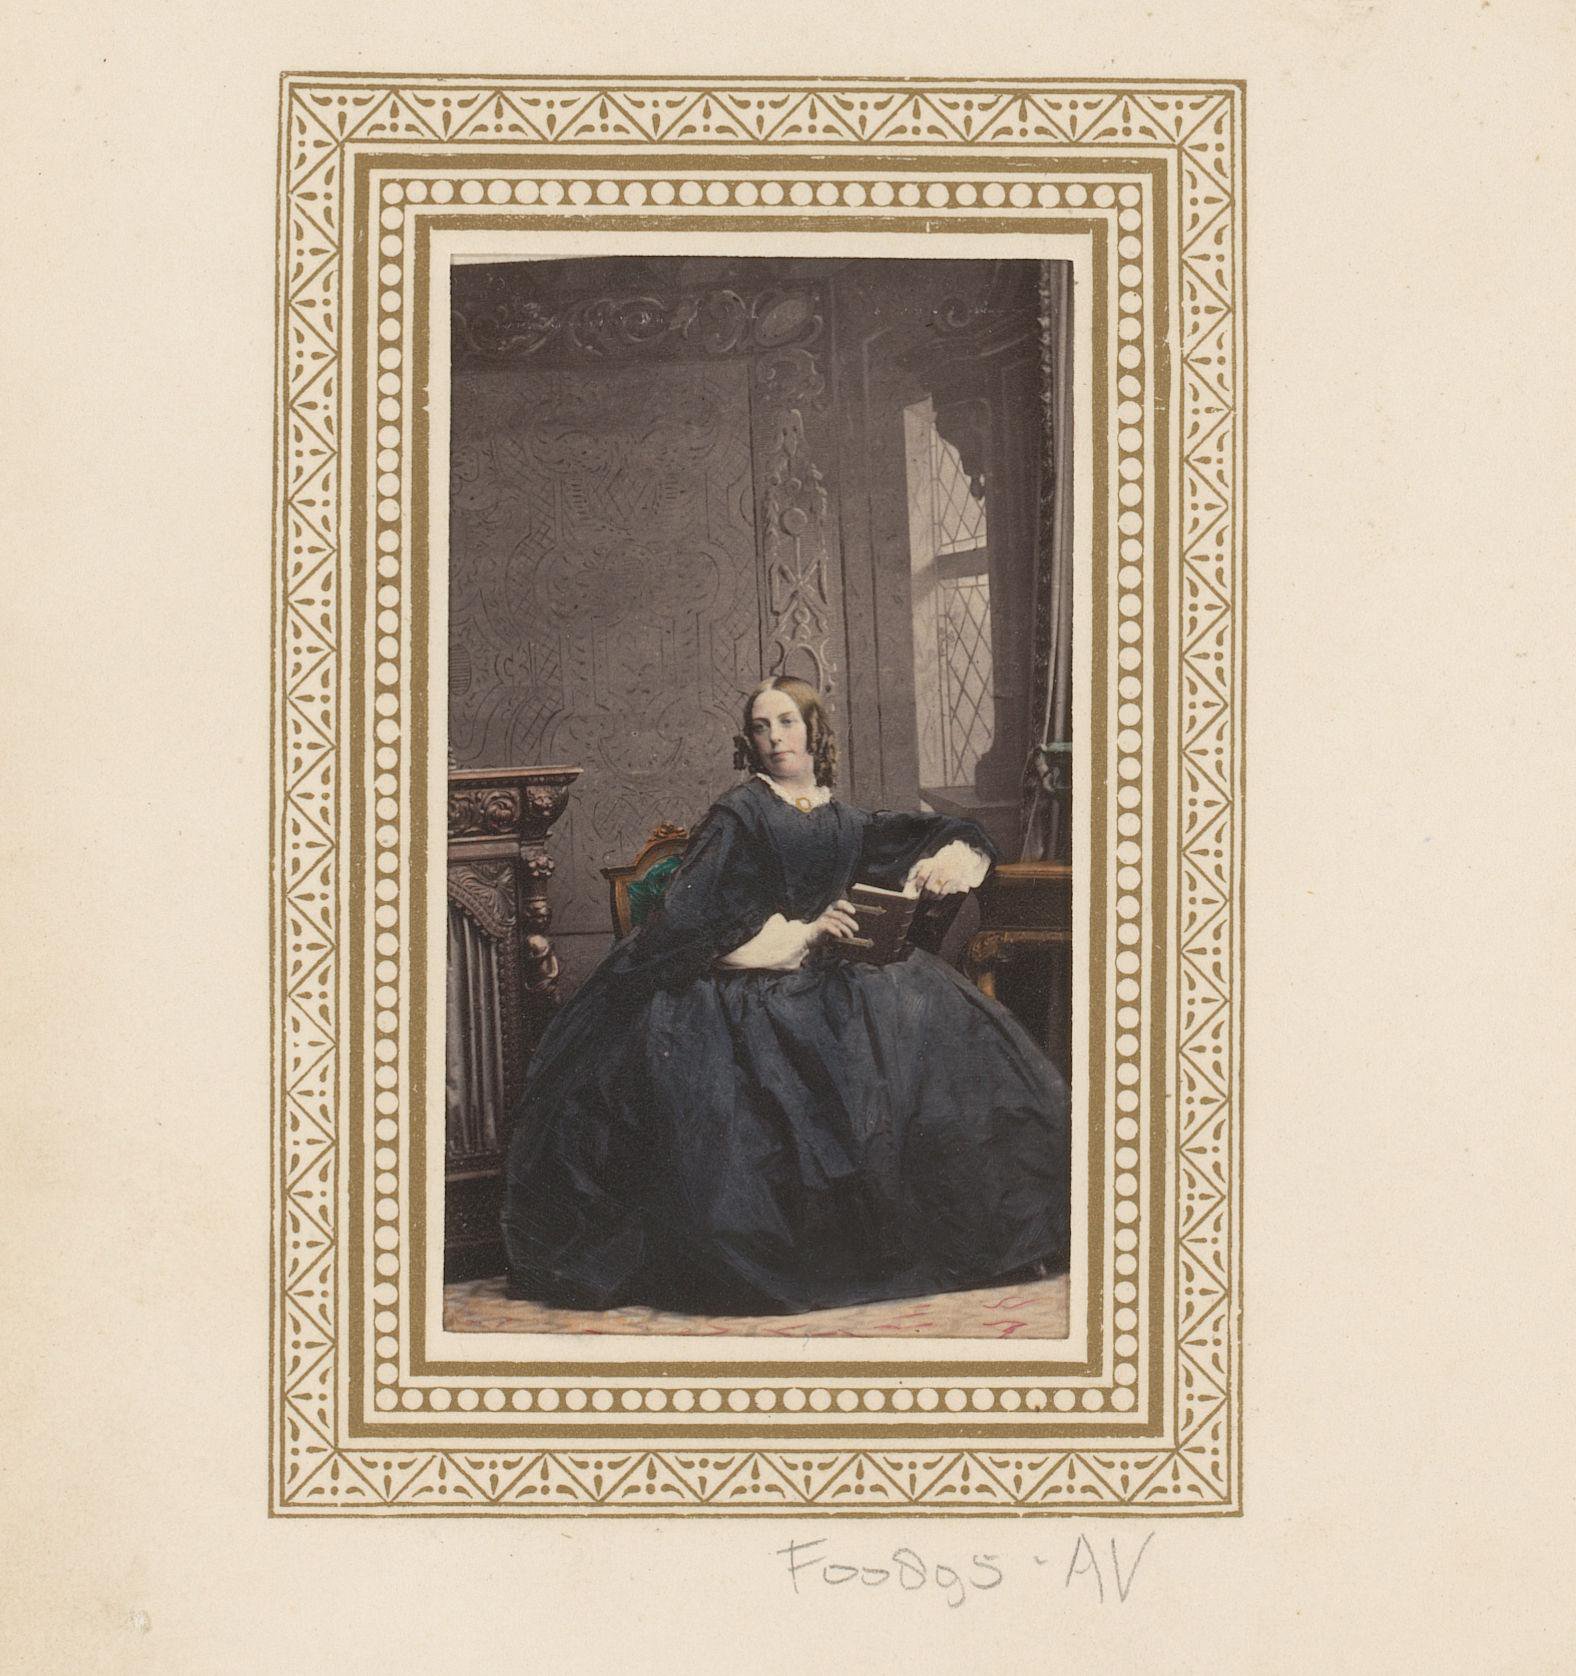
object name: photograph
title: Cartes-de-visite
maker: camille leon louis silvy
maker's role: fotograaf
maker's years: 1834-1910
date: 1859-1890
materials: cardboard, photographic support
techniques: albumen print, hand coloring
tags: sitting figure - aa - female human figure, historical persons, book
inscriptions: inscription: ‘Photographed by/ S. Silvy/ 38 Porchester Terrace/ Bayswater W.’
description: Cartomanie was a collecting craze. From 1855 hundreds of thousands of these portraits were annually sold worldwide. People had photographs taken of their loved ones, including their pets, and kept them in an album. Portraits of kings, writers, artists, actors, and statesmen were also collected. Photography was no longer the preserve of the wealthy; farmers and maidservants now also stood before the camera.